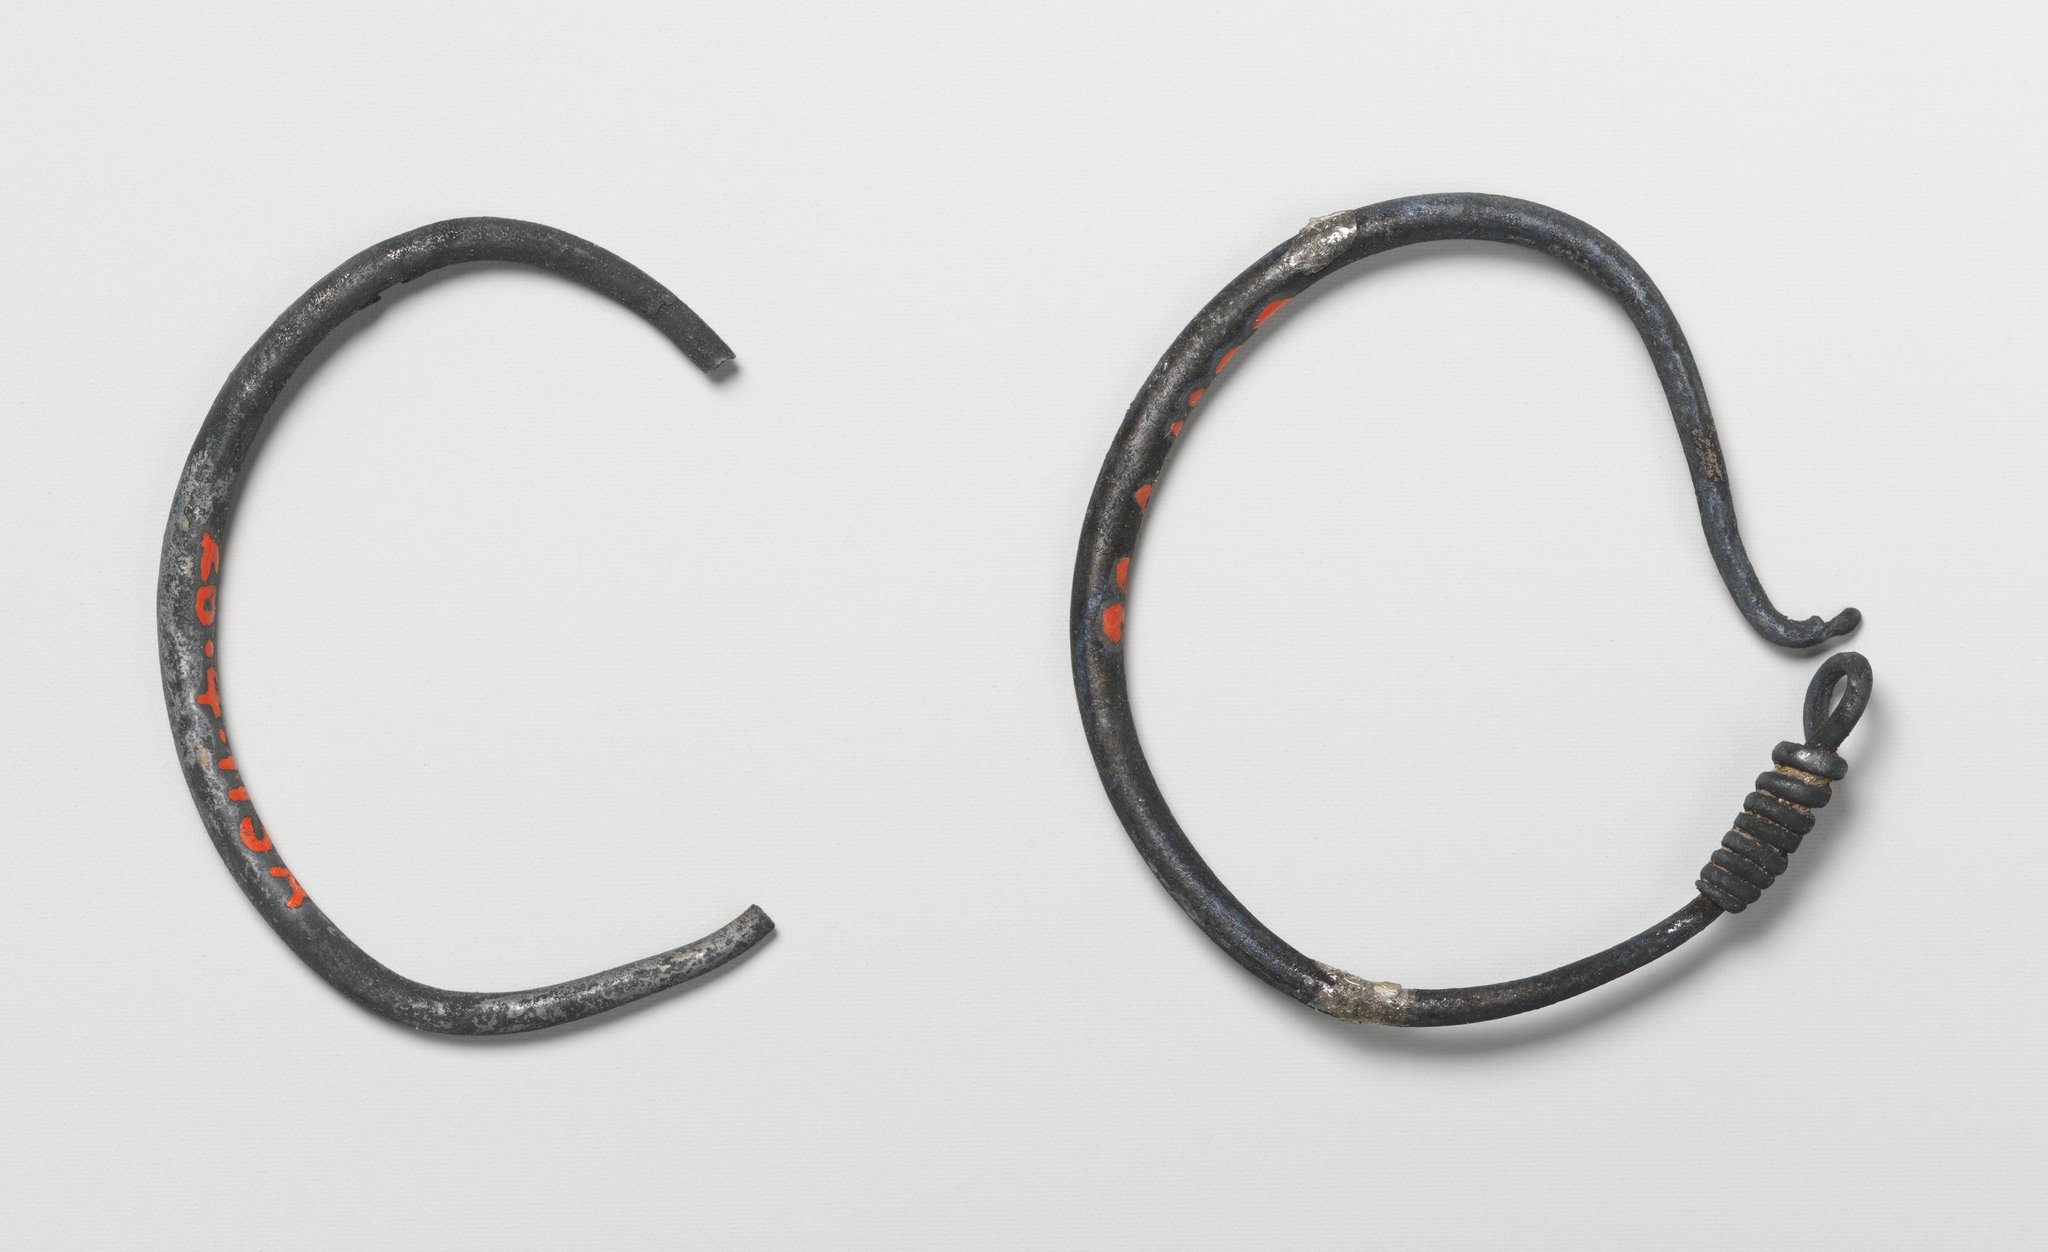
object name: earring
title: A pair of earrings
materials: copper alloy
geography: nubia